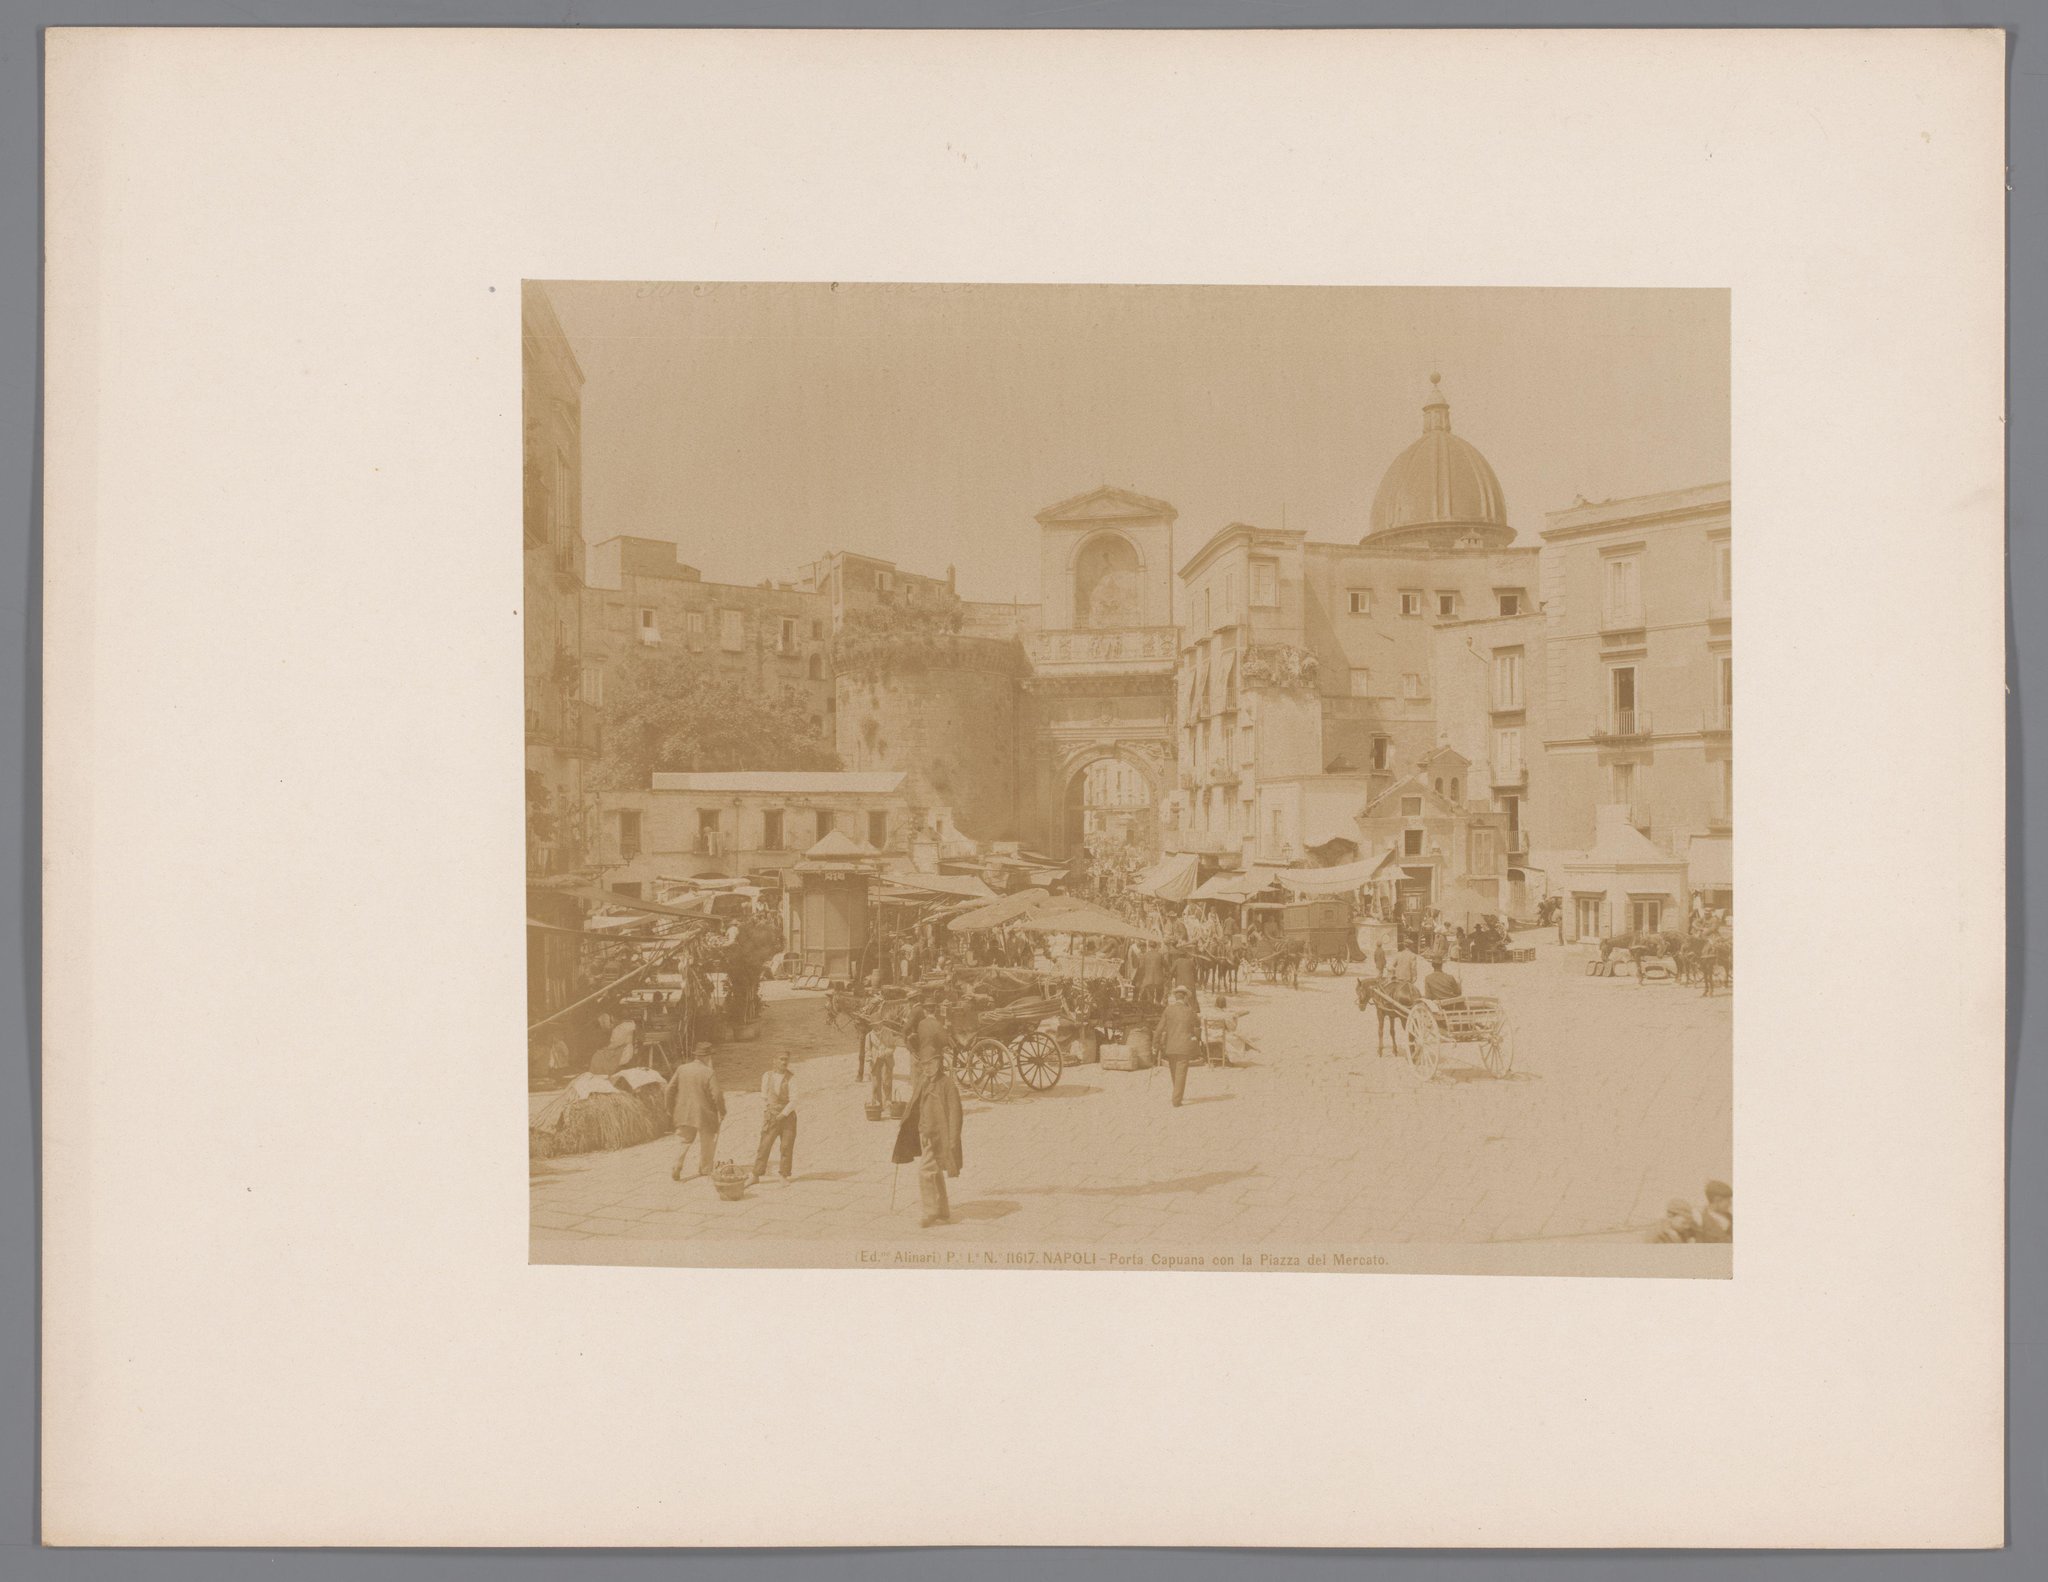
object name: photograph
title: Porta Capuana con la Piazza del Mercato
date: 1852-1890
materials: cardboard, paper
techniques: albumen print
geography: naples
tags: square, place, circus, etc., parts of church exterior and annexes: dome, market, city-gate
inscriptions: number: ‘P.o I.o N.o 11617.’